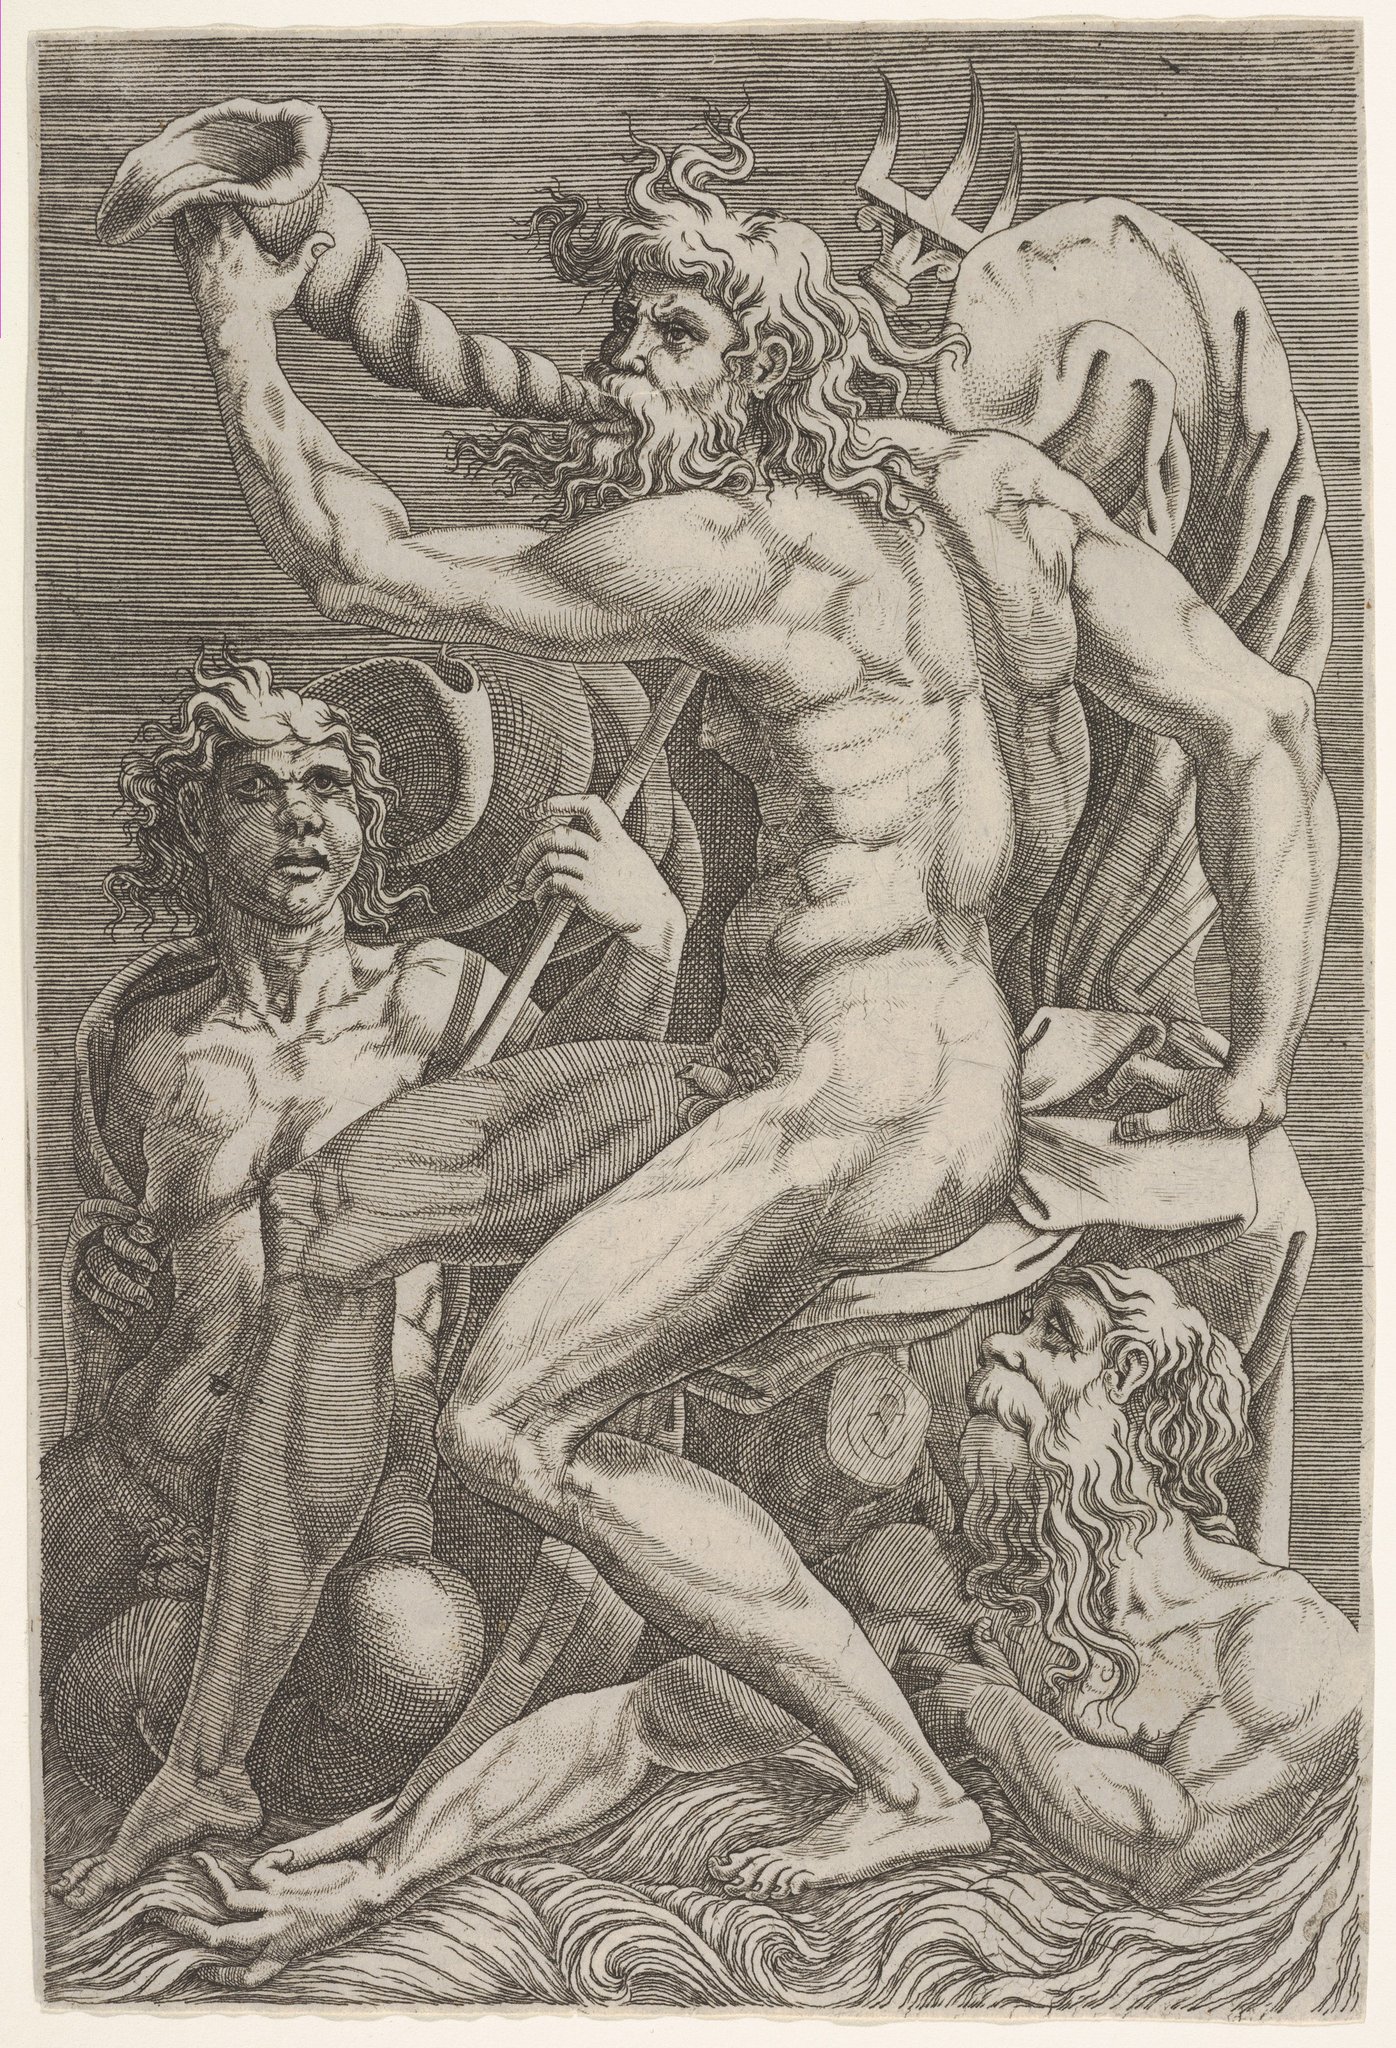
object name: print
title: Seated Neptune holding a conch shell to his mouth, accompanied by a seated triton and another emerging from the water at bottom right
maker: giorgio ghisi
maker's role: artist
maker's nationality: italian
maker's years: 1515-1582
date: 1510-1590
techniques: engraving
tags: triton,neptune,shells